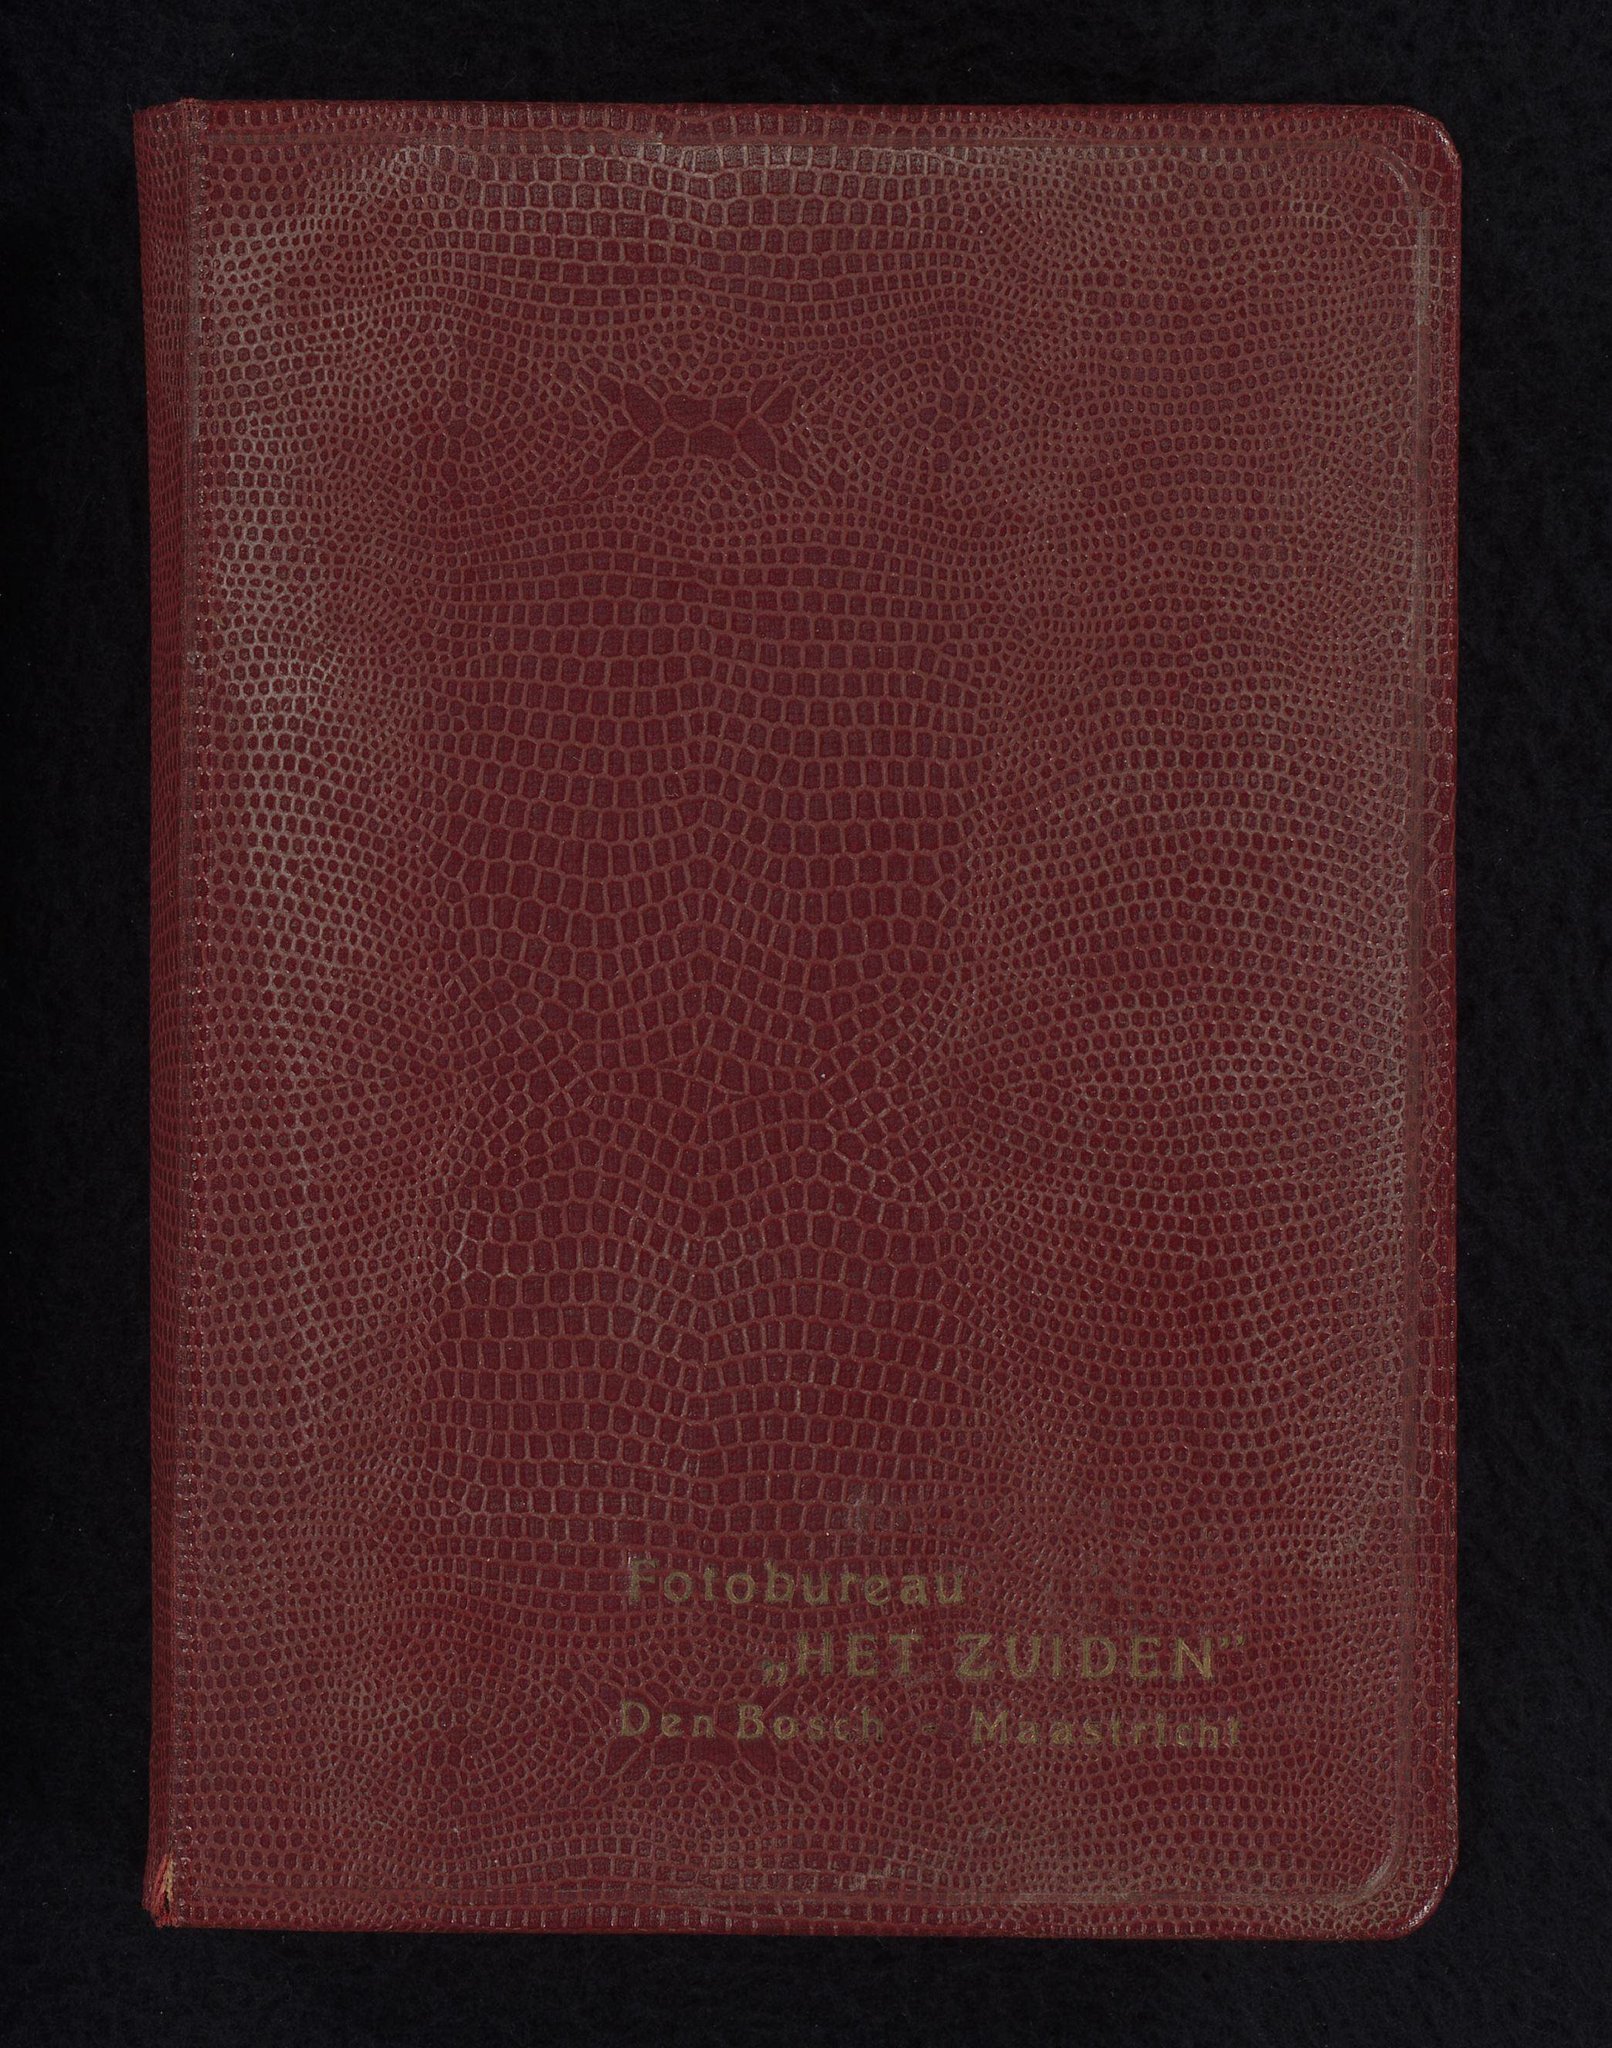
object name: photograph album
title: Leporelloalbum met 42 foto's van een katholieke priester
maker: Anonymous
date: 1956-1958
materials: paper, leather, textile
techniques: gelatin silver print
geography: netherlands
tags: divine service ~ christian churches, preaching (in general), priests ~ hierarchy of priests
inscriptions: inscription: ‘0704BMI/ foto's Jan Fonteyn 1956/ €70,-’, inscription: ‘Fotobureau/ "Het Zuiden"/ Den Bosch - Maastricht’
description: Leporelloalbum met 42 ontwikkelgelatinezilverdrukken van een priester bij de kerkdienst en feestelijkheden. Mogelijk was het album een geschenk of aandenken voor de priester. De foto's zijn gemaakt door een anonieme fotograaf van Fotobureau Het Zuiden, waarschijnlijk in Limburg.